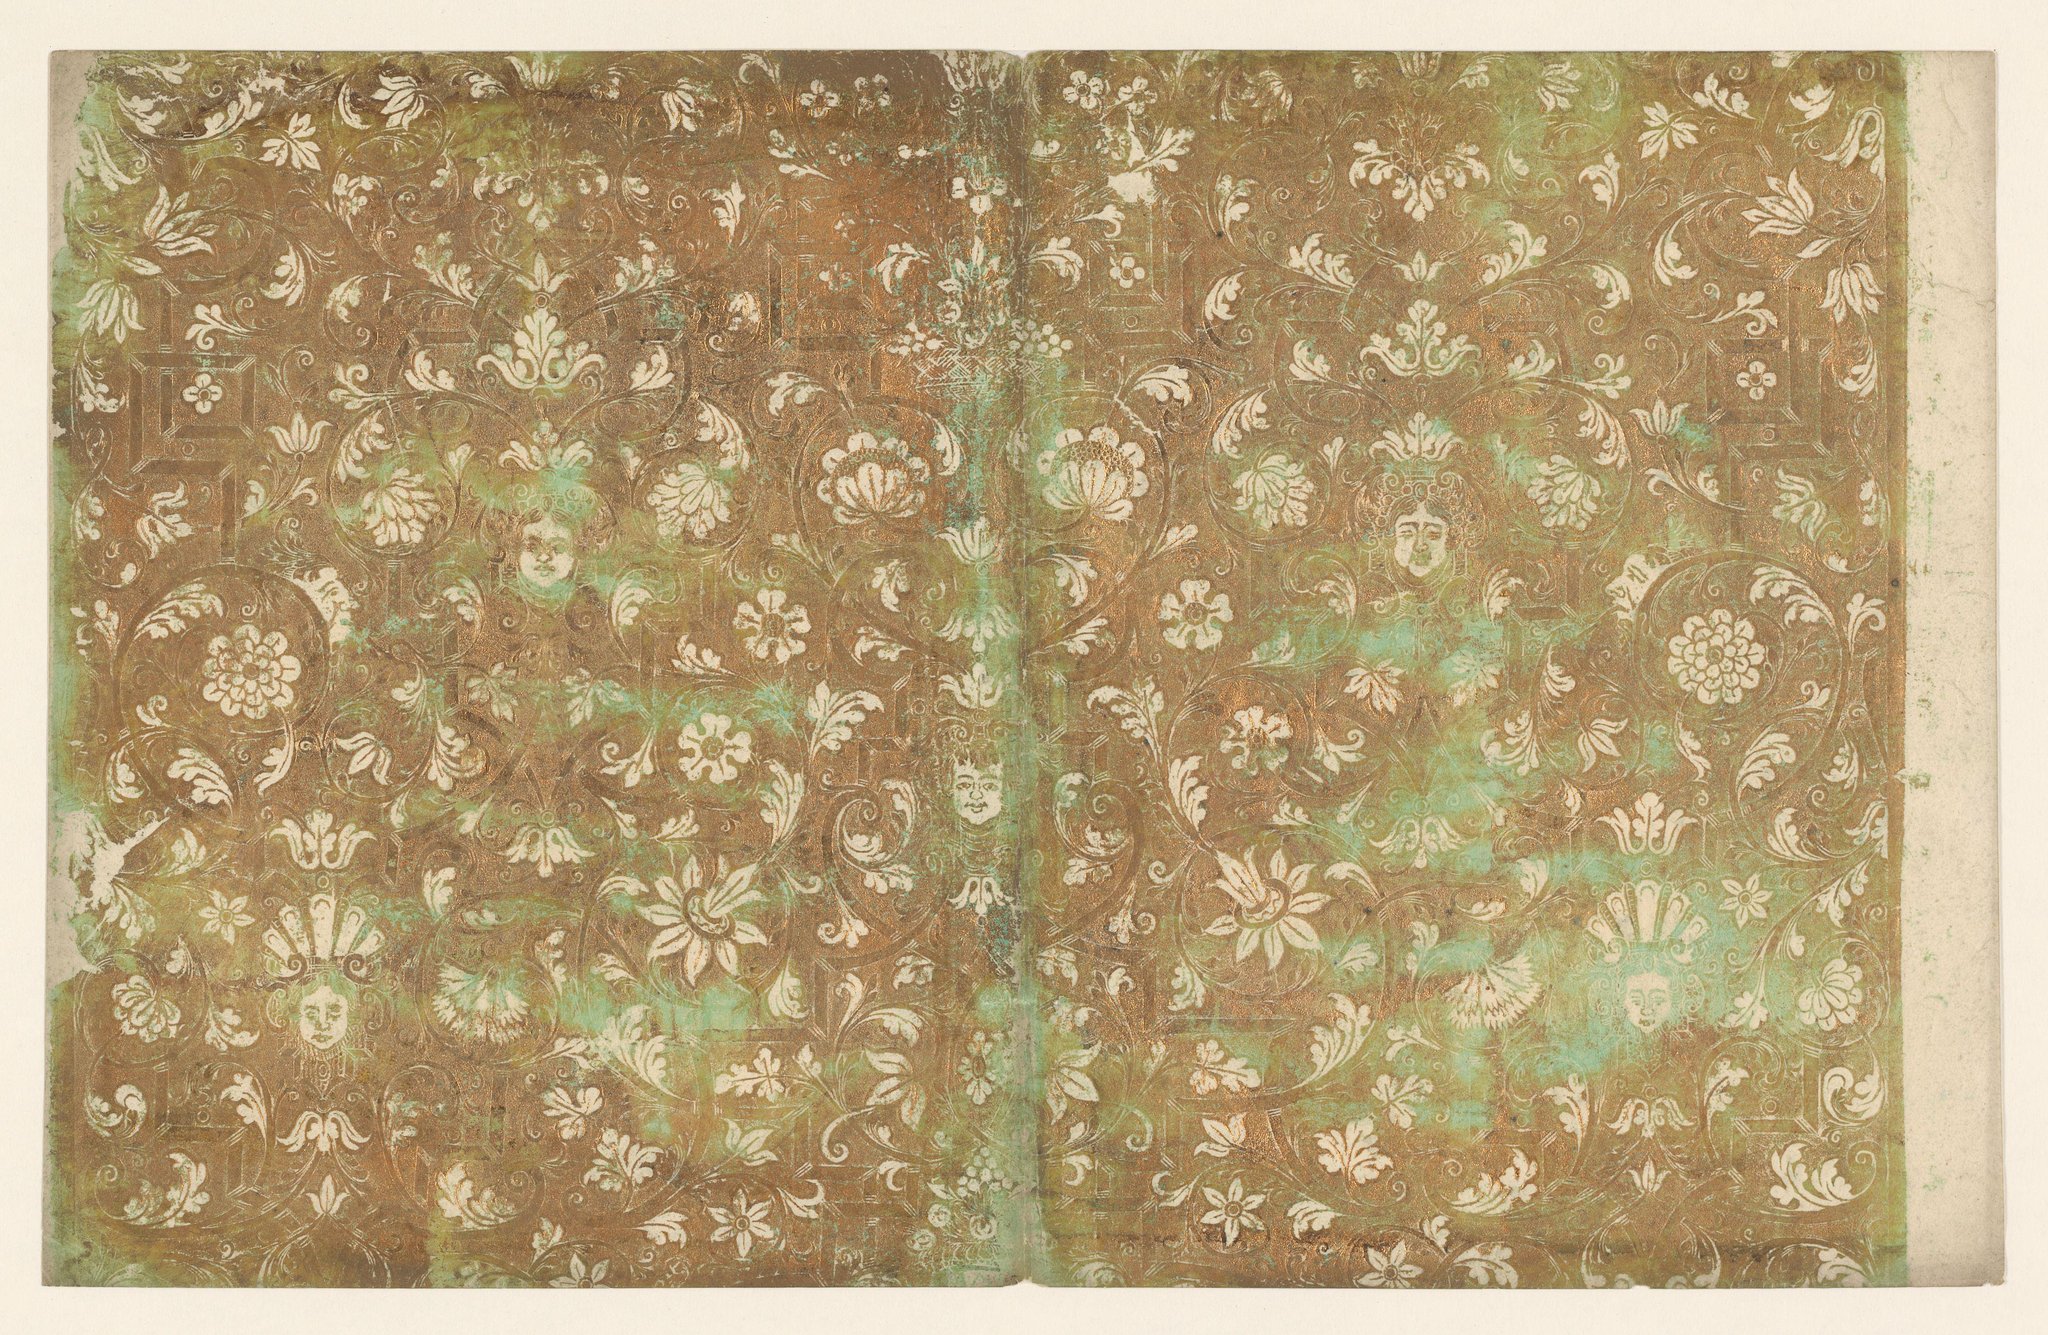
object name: wrapper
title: Blad met maskers tussen bladranken met bloemen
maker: Anonymous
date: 1700-1850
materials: gold leaf, paper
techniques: relief print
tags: mask, mascaron ~ ornament, ornament derived from plant forms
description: Blad met maskers tussen bladranken met bloemen en bandwerk. Links en rechts identieke helften. Gebruikt als omslag.